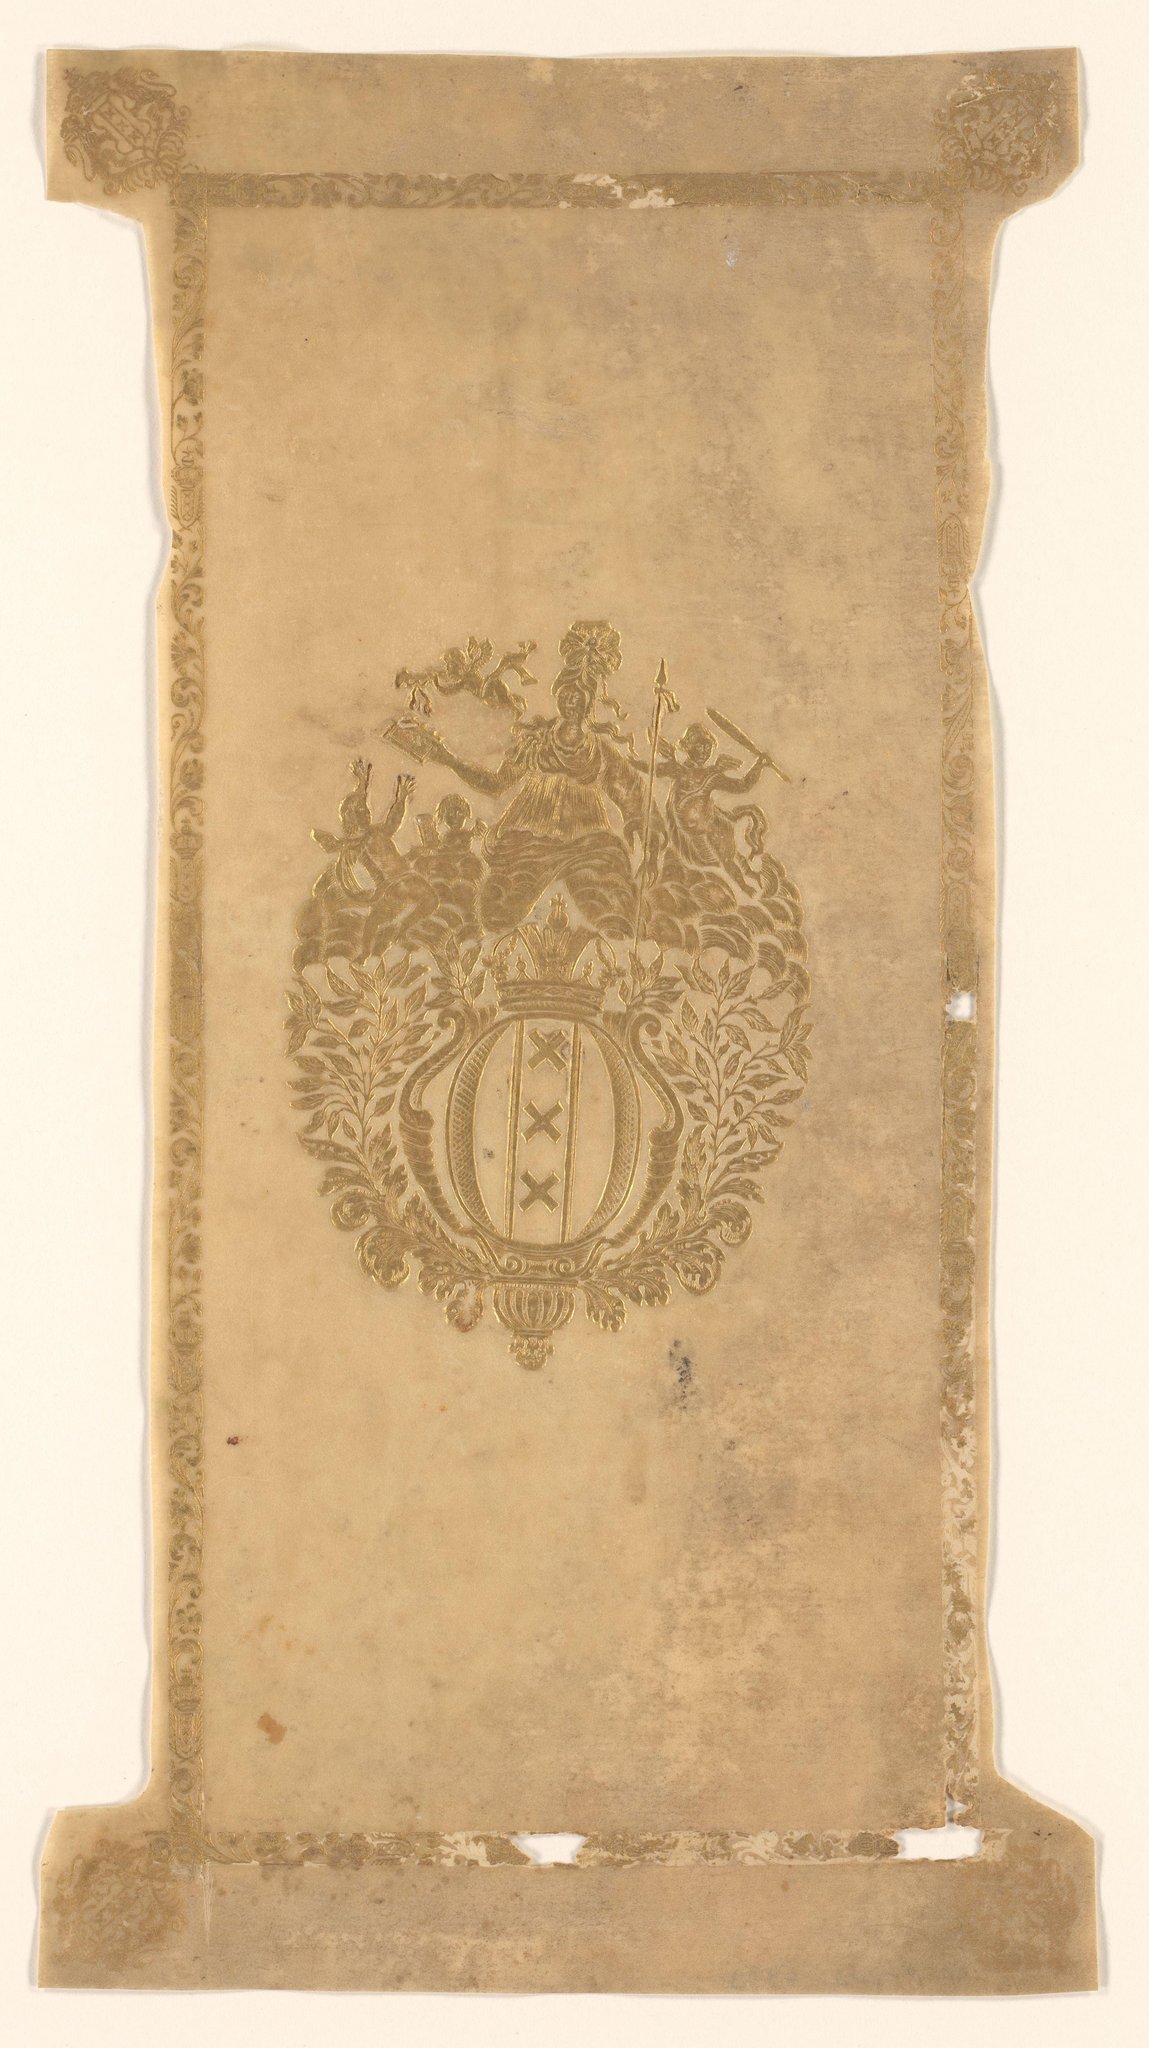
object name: binding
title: Stadswapen van Amsterdam met vrouwelijke personificatie en vier putti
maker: Anonymous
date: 1650-1800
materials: gold leaf, parchment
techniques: printing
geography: amsterdam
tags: coat of arms (as symbol of the state, etc.) (+ city; municipal), cupids: 'amores', 'amoretti', 'putti', amsterdam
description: Vermoedelijk een boekband voor een prijsband.